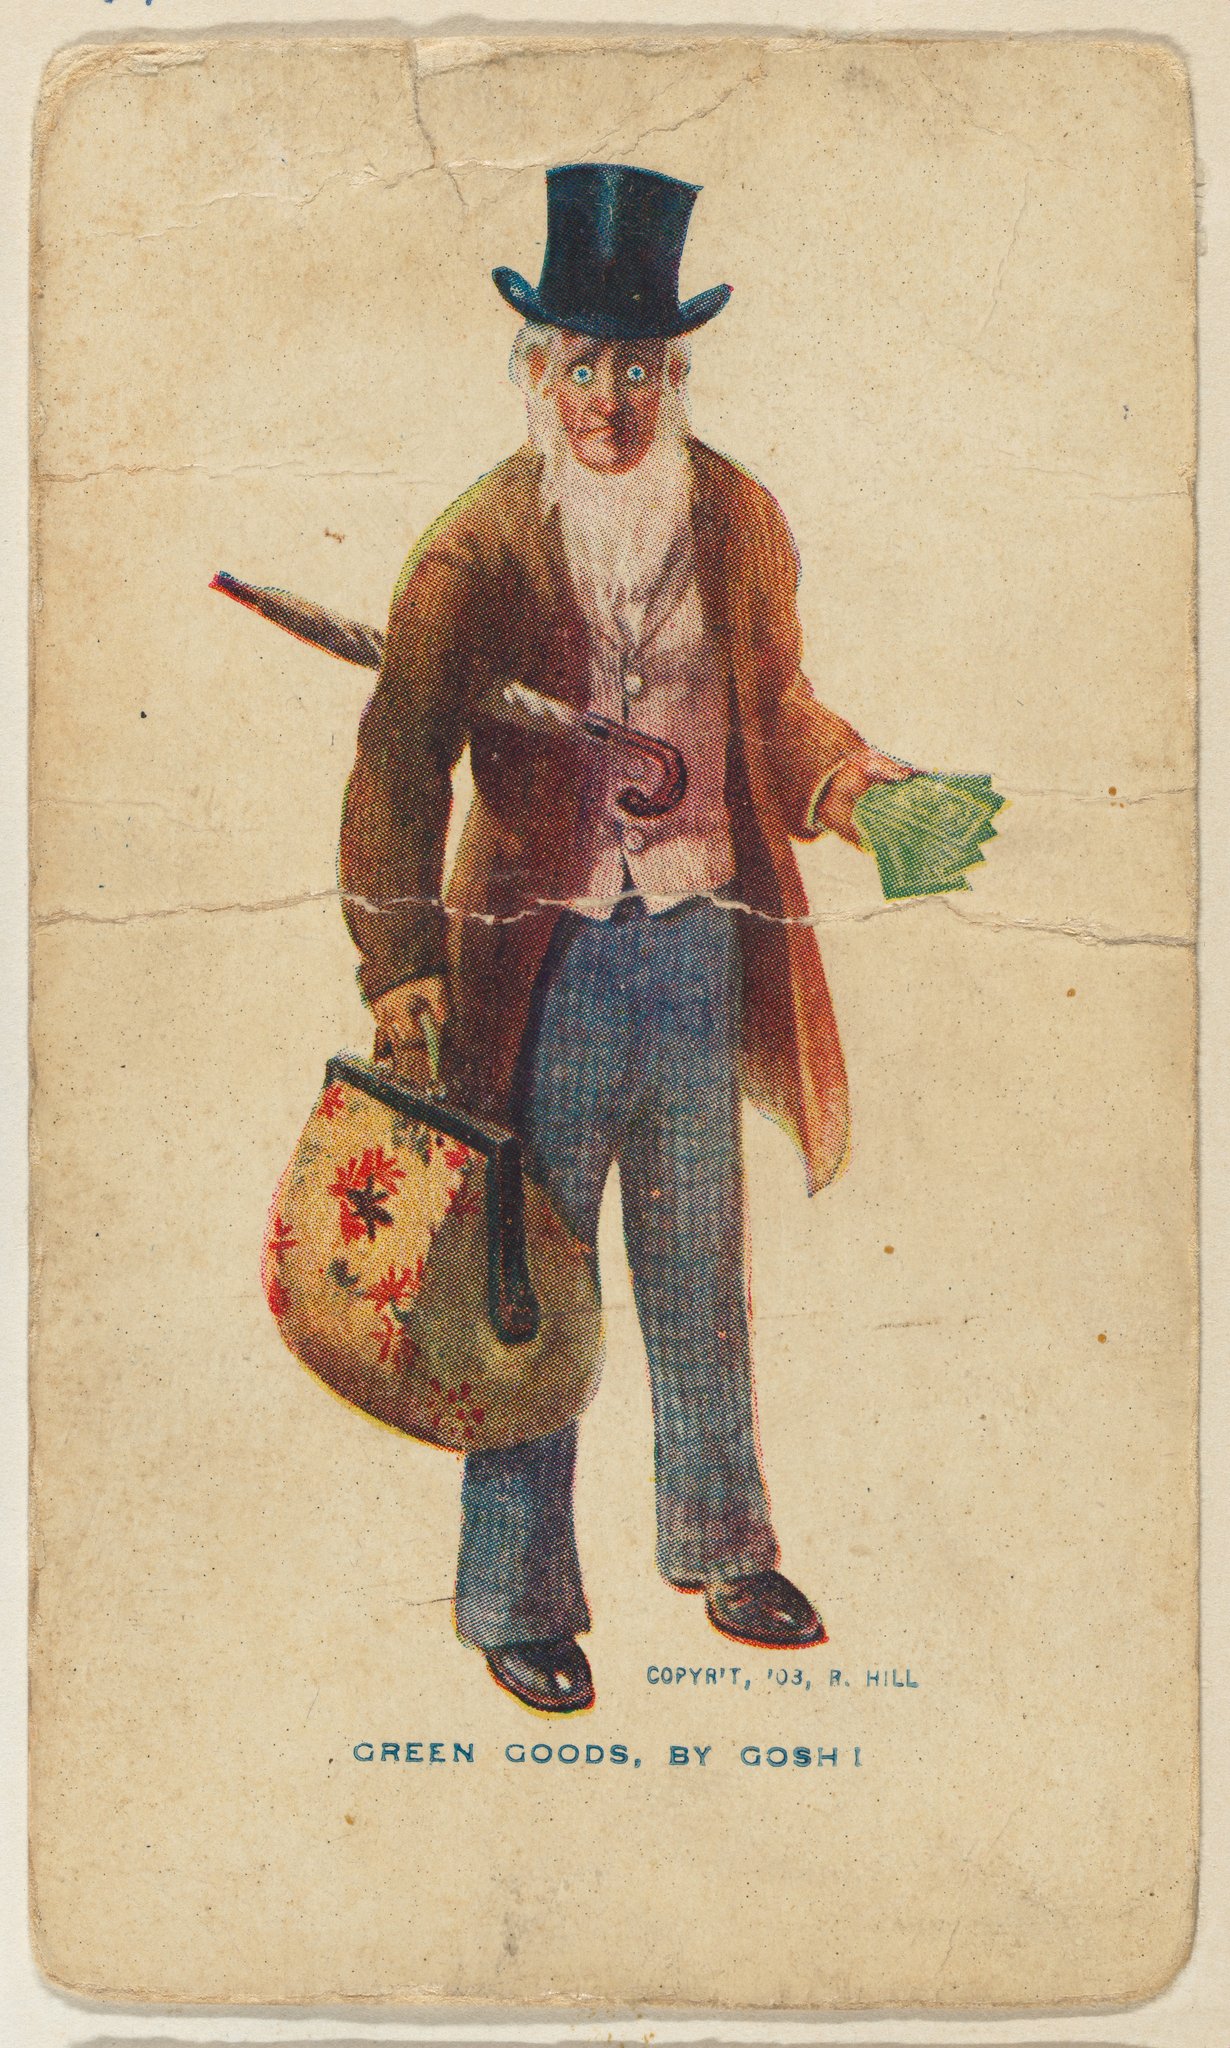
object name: print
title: Green Goods, by Gosh!, from the "Girls and Men in Costume" series (T65), issued with Golden Eagle Cigars by I. Lewis & Co.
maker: i. lewis & co., newark, new jersey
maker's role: publisher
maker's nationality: american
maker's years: 1850-1950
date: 1903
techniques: color lithograph